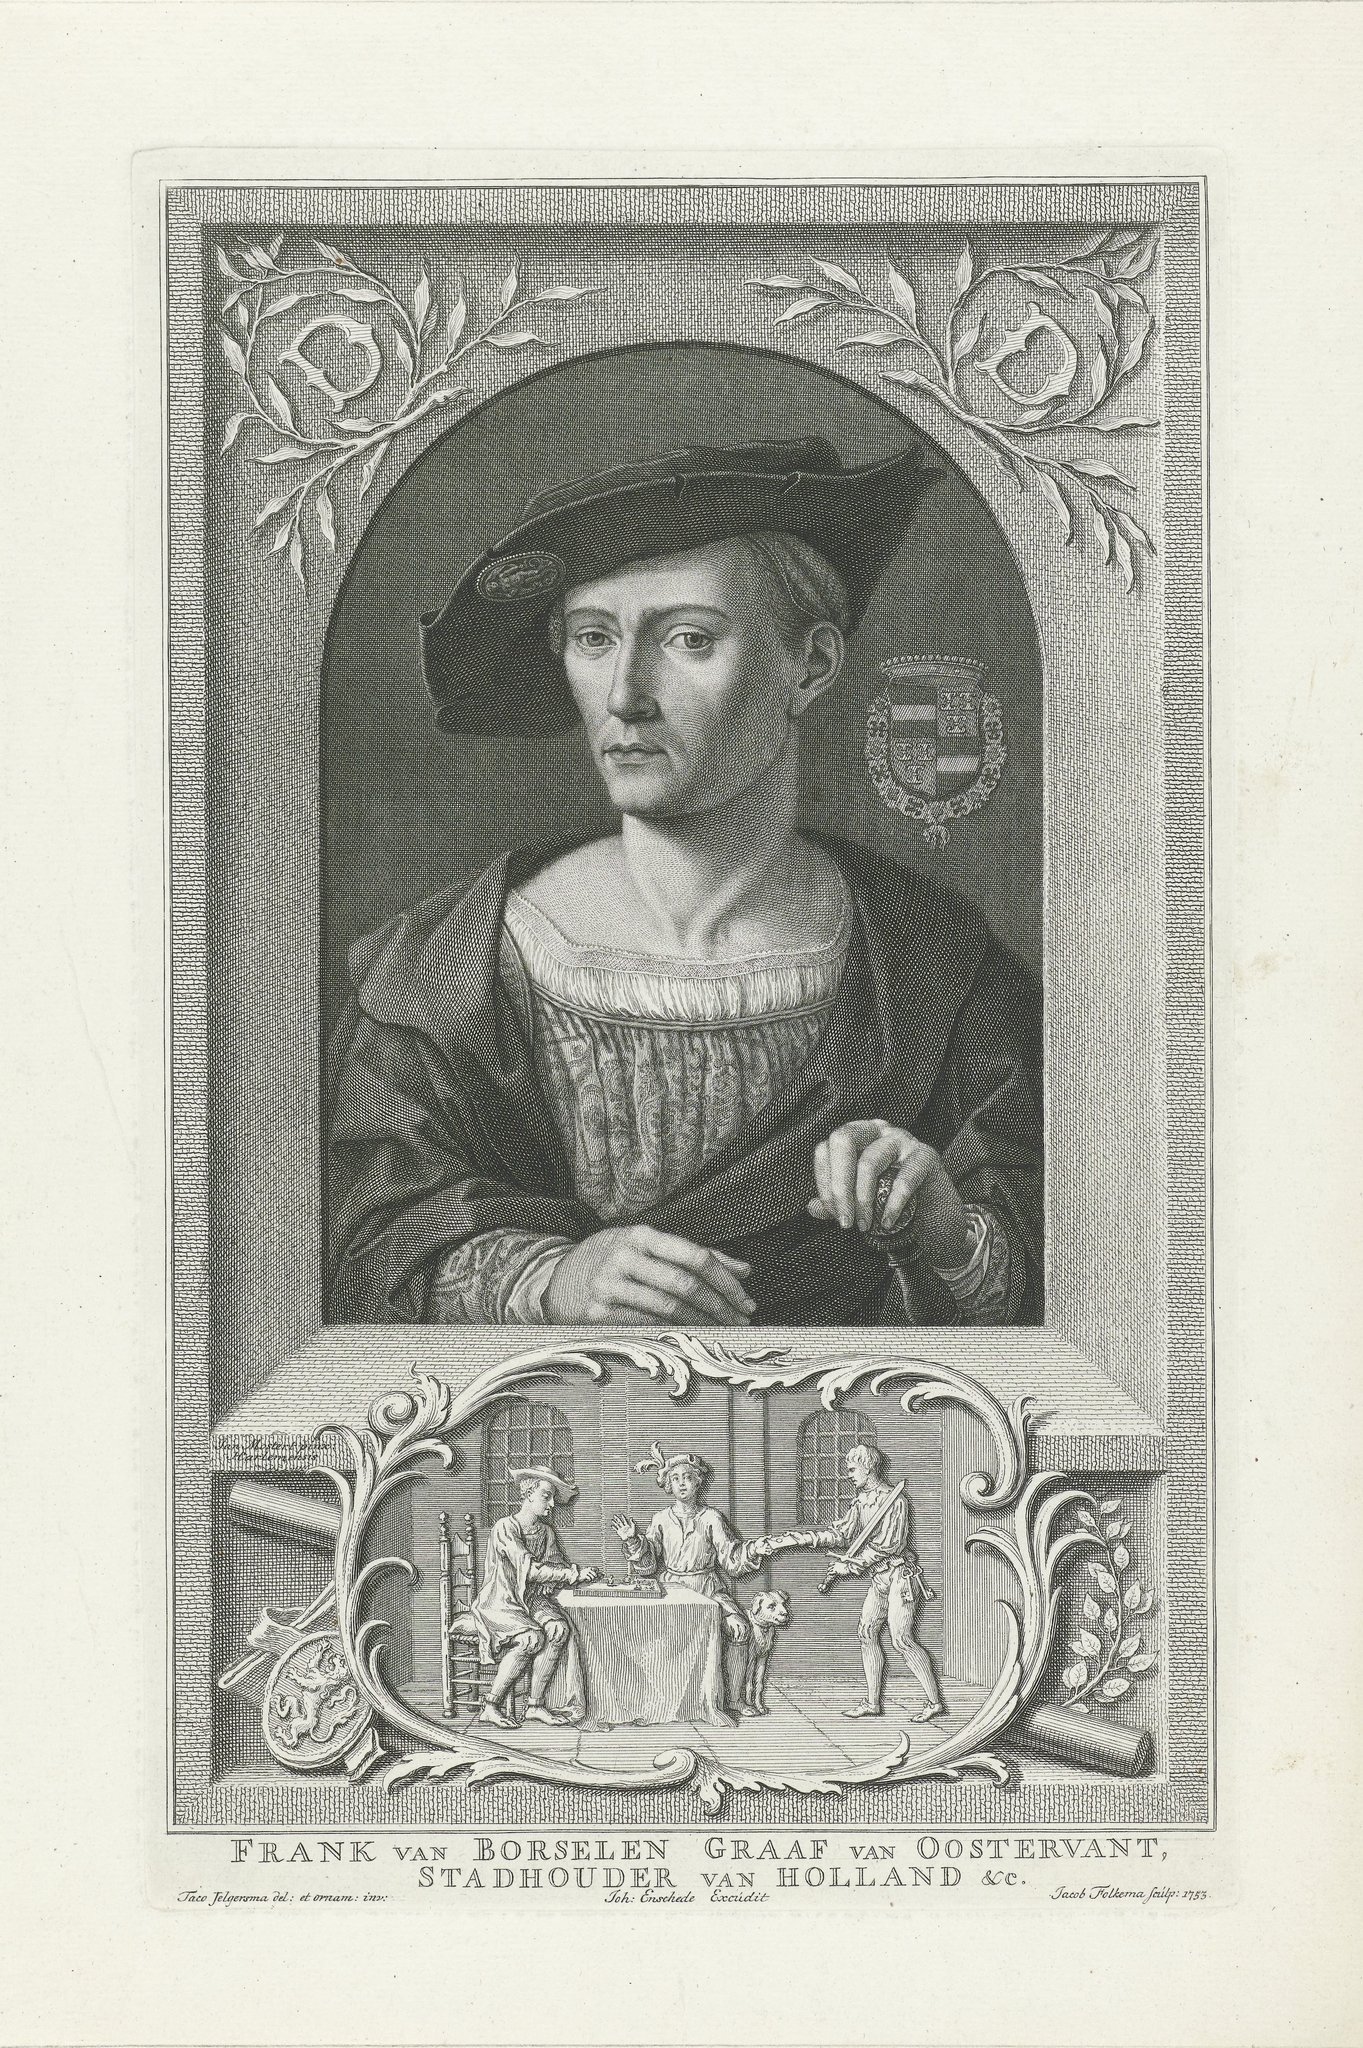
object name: print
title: Portret van Frank van Borselen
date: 1753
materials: paper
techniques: etching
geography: haarlem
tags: brielle, board-games (+ sportsman, player, etc.)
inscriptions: collector's mark: Lugt 2228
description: Portret ten halven lijve van voren onder een toog van de Zeeuwse edelman Frank van Borselen, met hoed. Rechts van de edelman is een gekroond wapenschild weergegeven. Onder het portret is een spel spelend gezelschap afgebeeld, omgeven door een sierlijke lijst. In de marge staan de naam en titels van de geportretteerde.